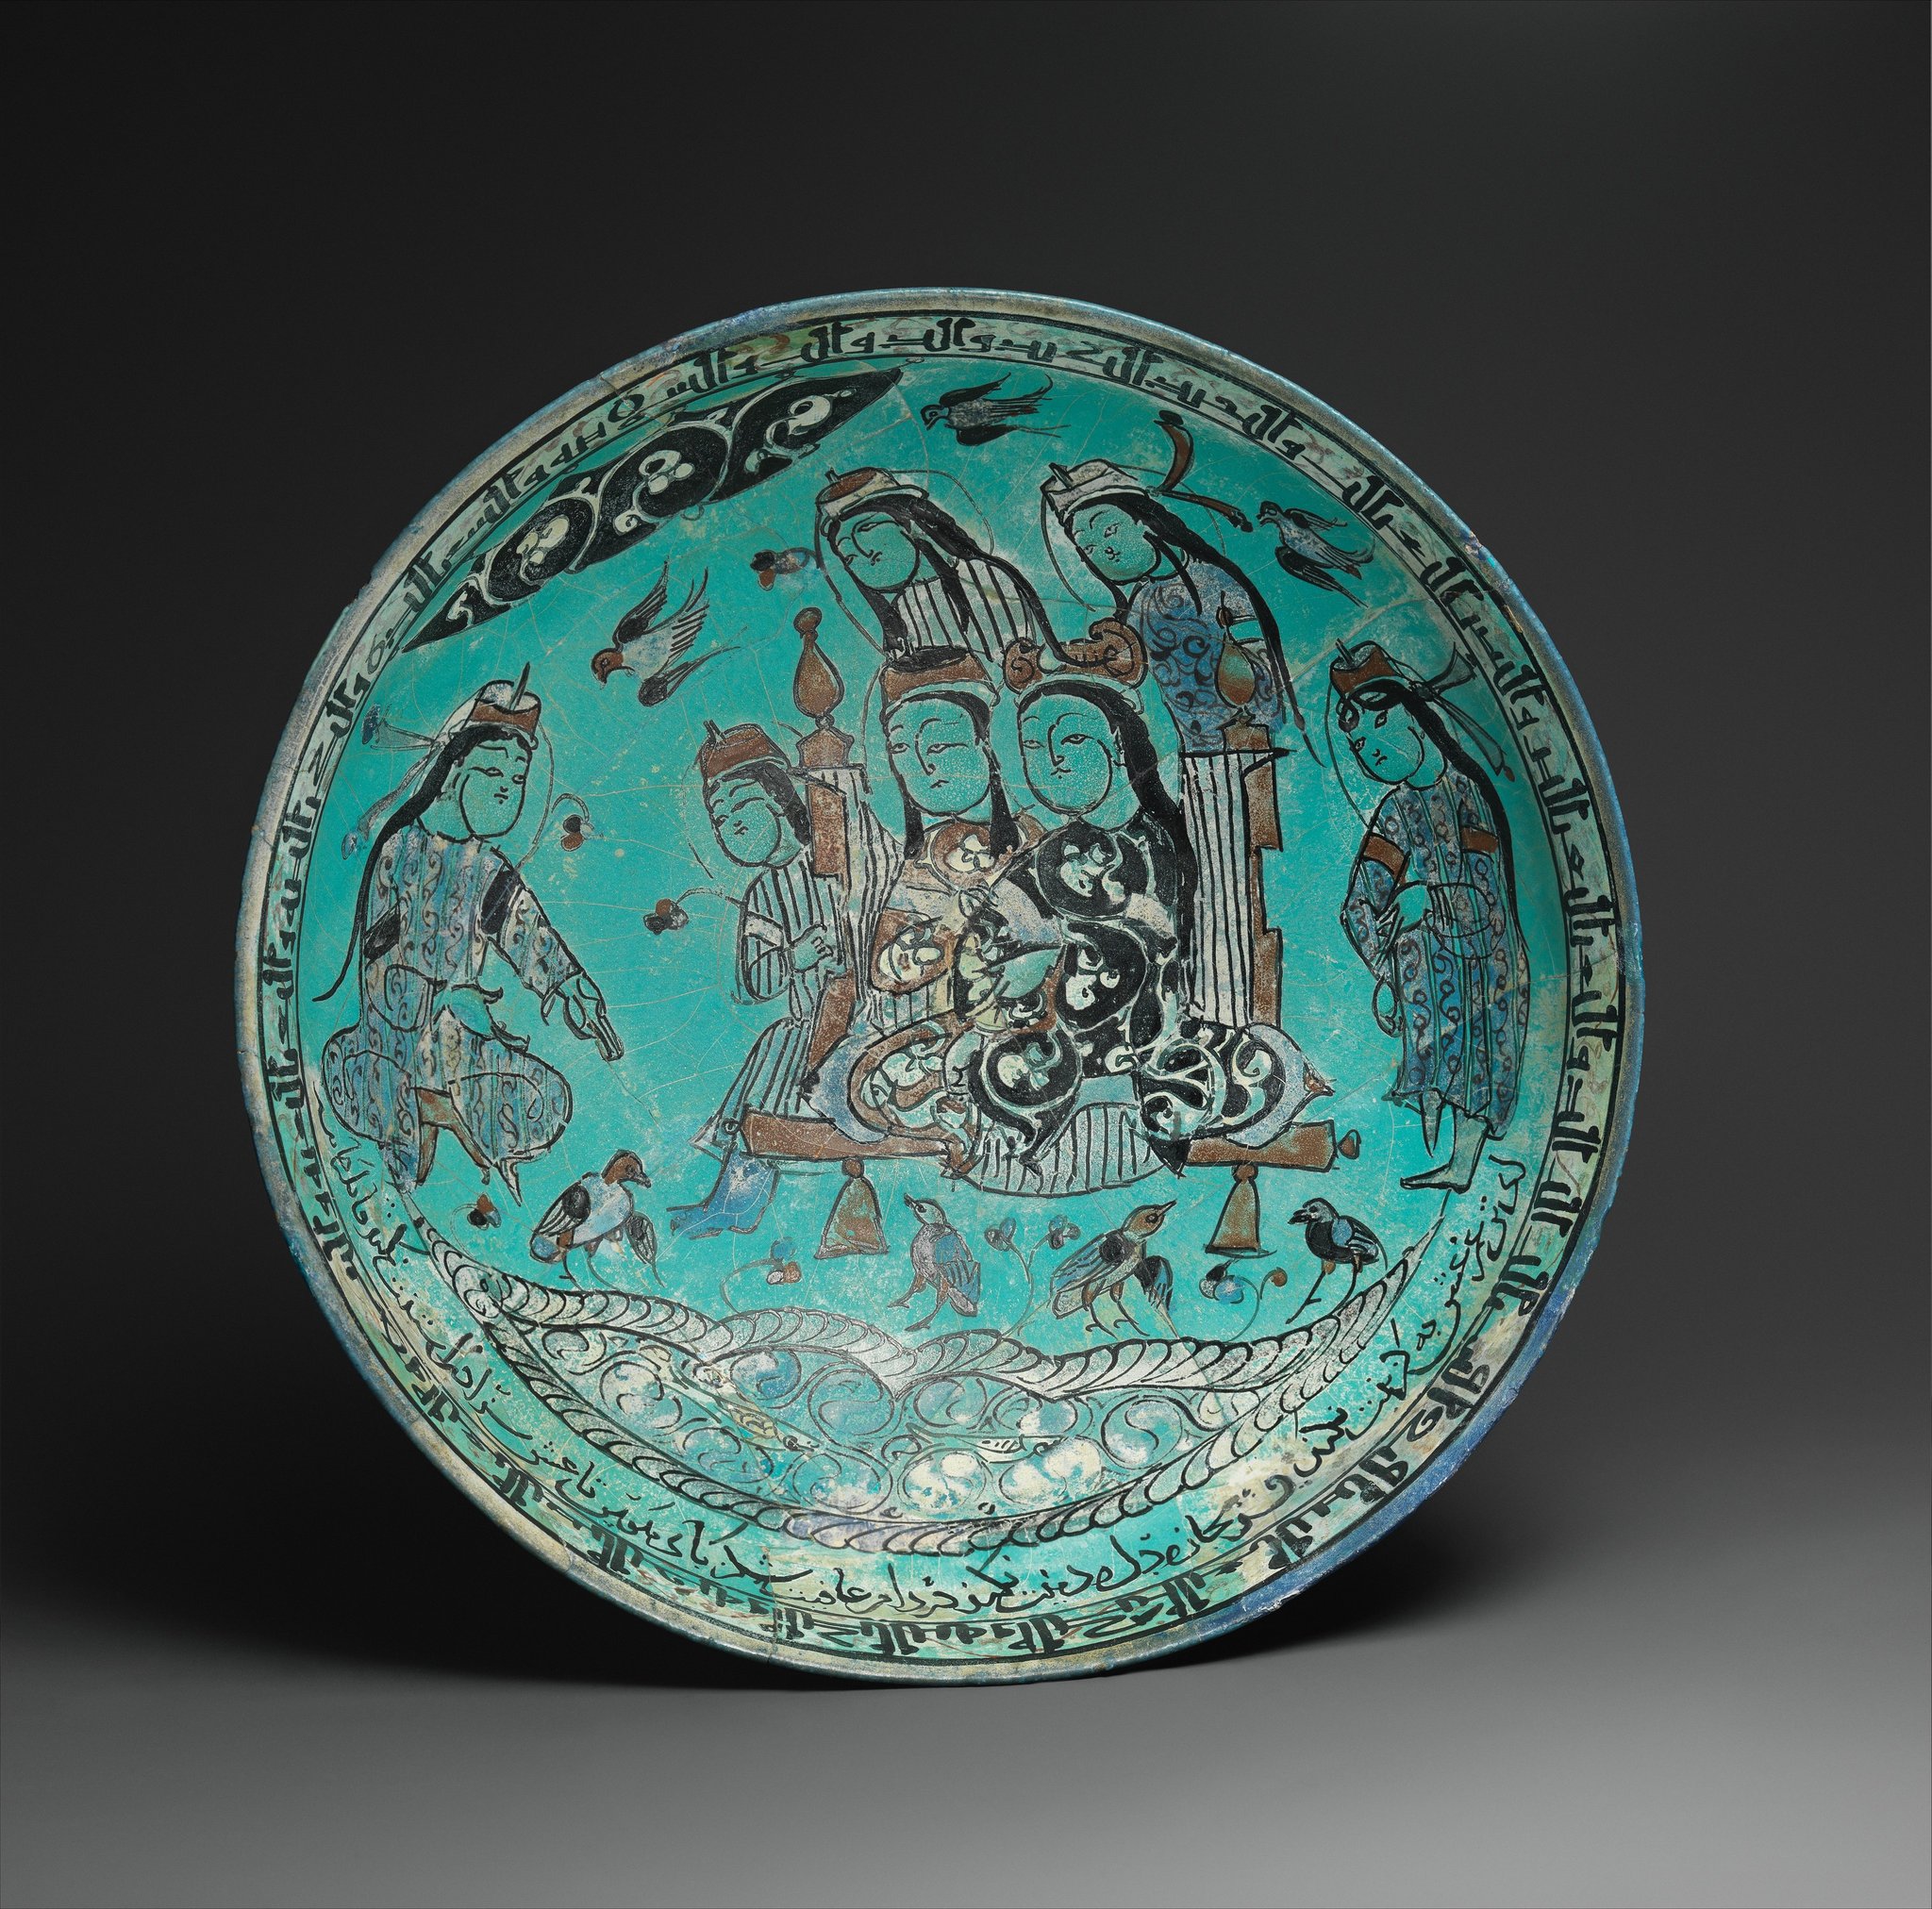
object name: bowl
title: Bowl with a Majlis Scene by a Pond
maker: abu zayd al-kashani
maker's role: maker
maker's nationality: iranian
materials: glaze, stonepaste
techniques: glazing, overglaze, painting, polychrome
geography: iran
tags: birds,women